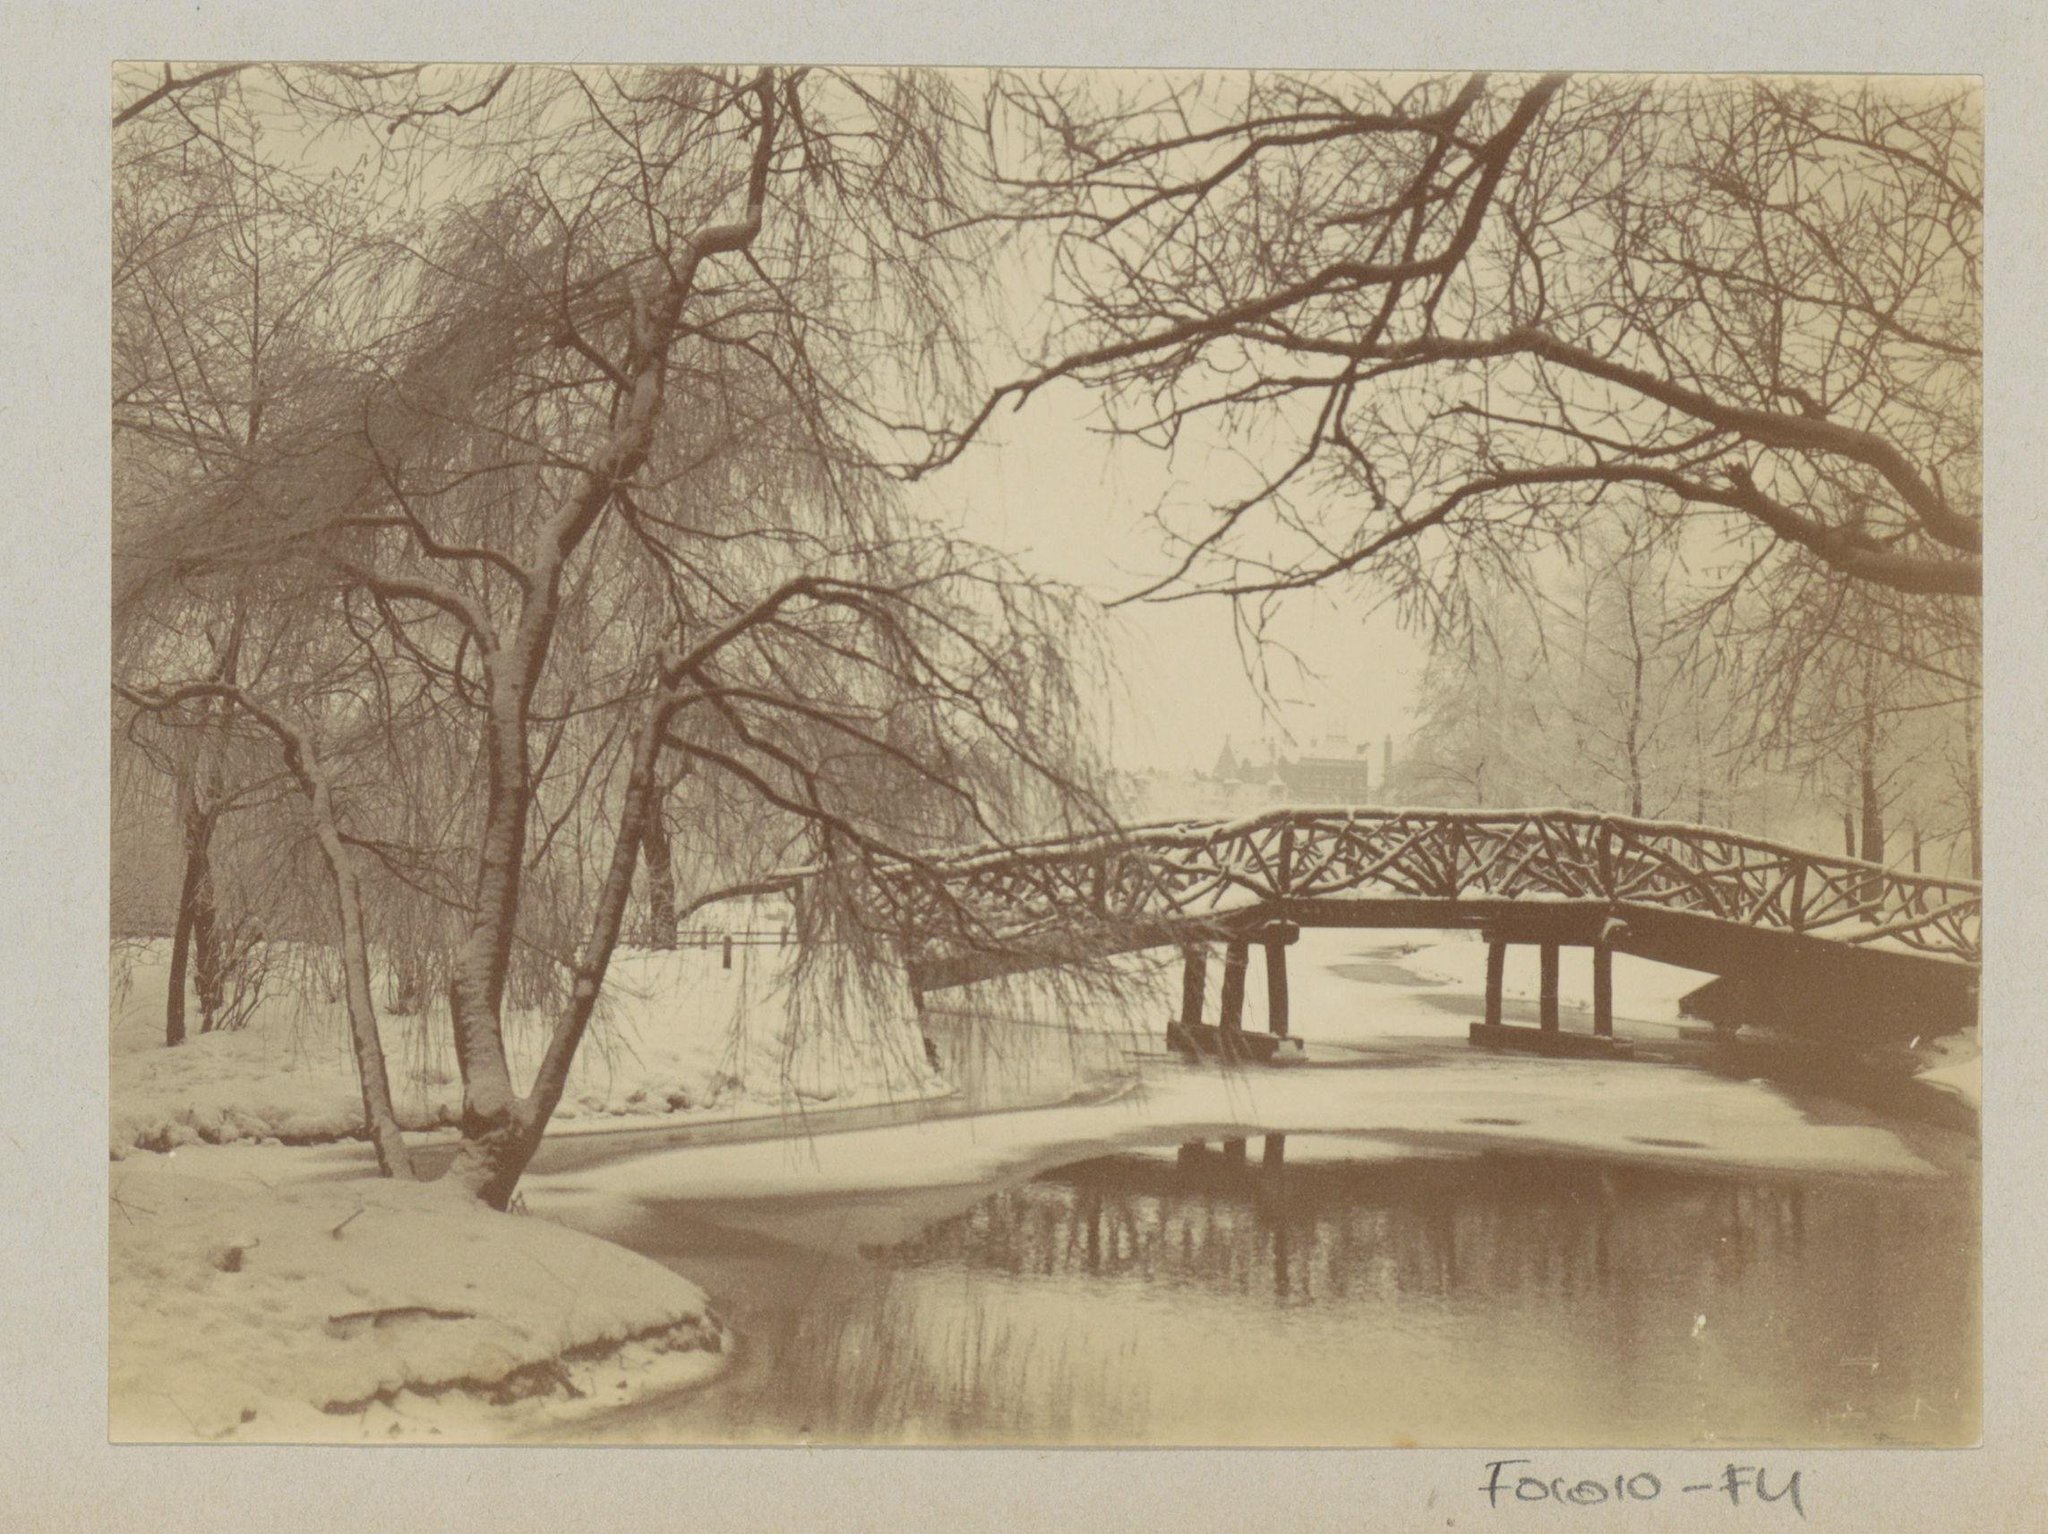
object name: photograph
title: Besneeuwde vijver met een brug in een park, mogelijk Amsterdam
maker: Anonymous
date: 1900-1910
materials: photographic support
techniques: daylight paper print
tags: trees, winter landscape; landscape symbolizing winter (the four seasons of the year), snow, bridge, public gardens, park, amsterdam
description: Onderdeel van Familiealbum met onder meer foto's van Wijnhandel Kraaij & Co. Bordeaux-Amsterdam.